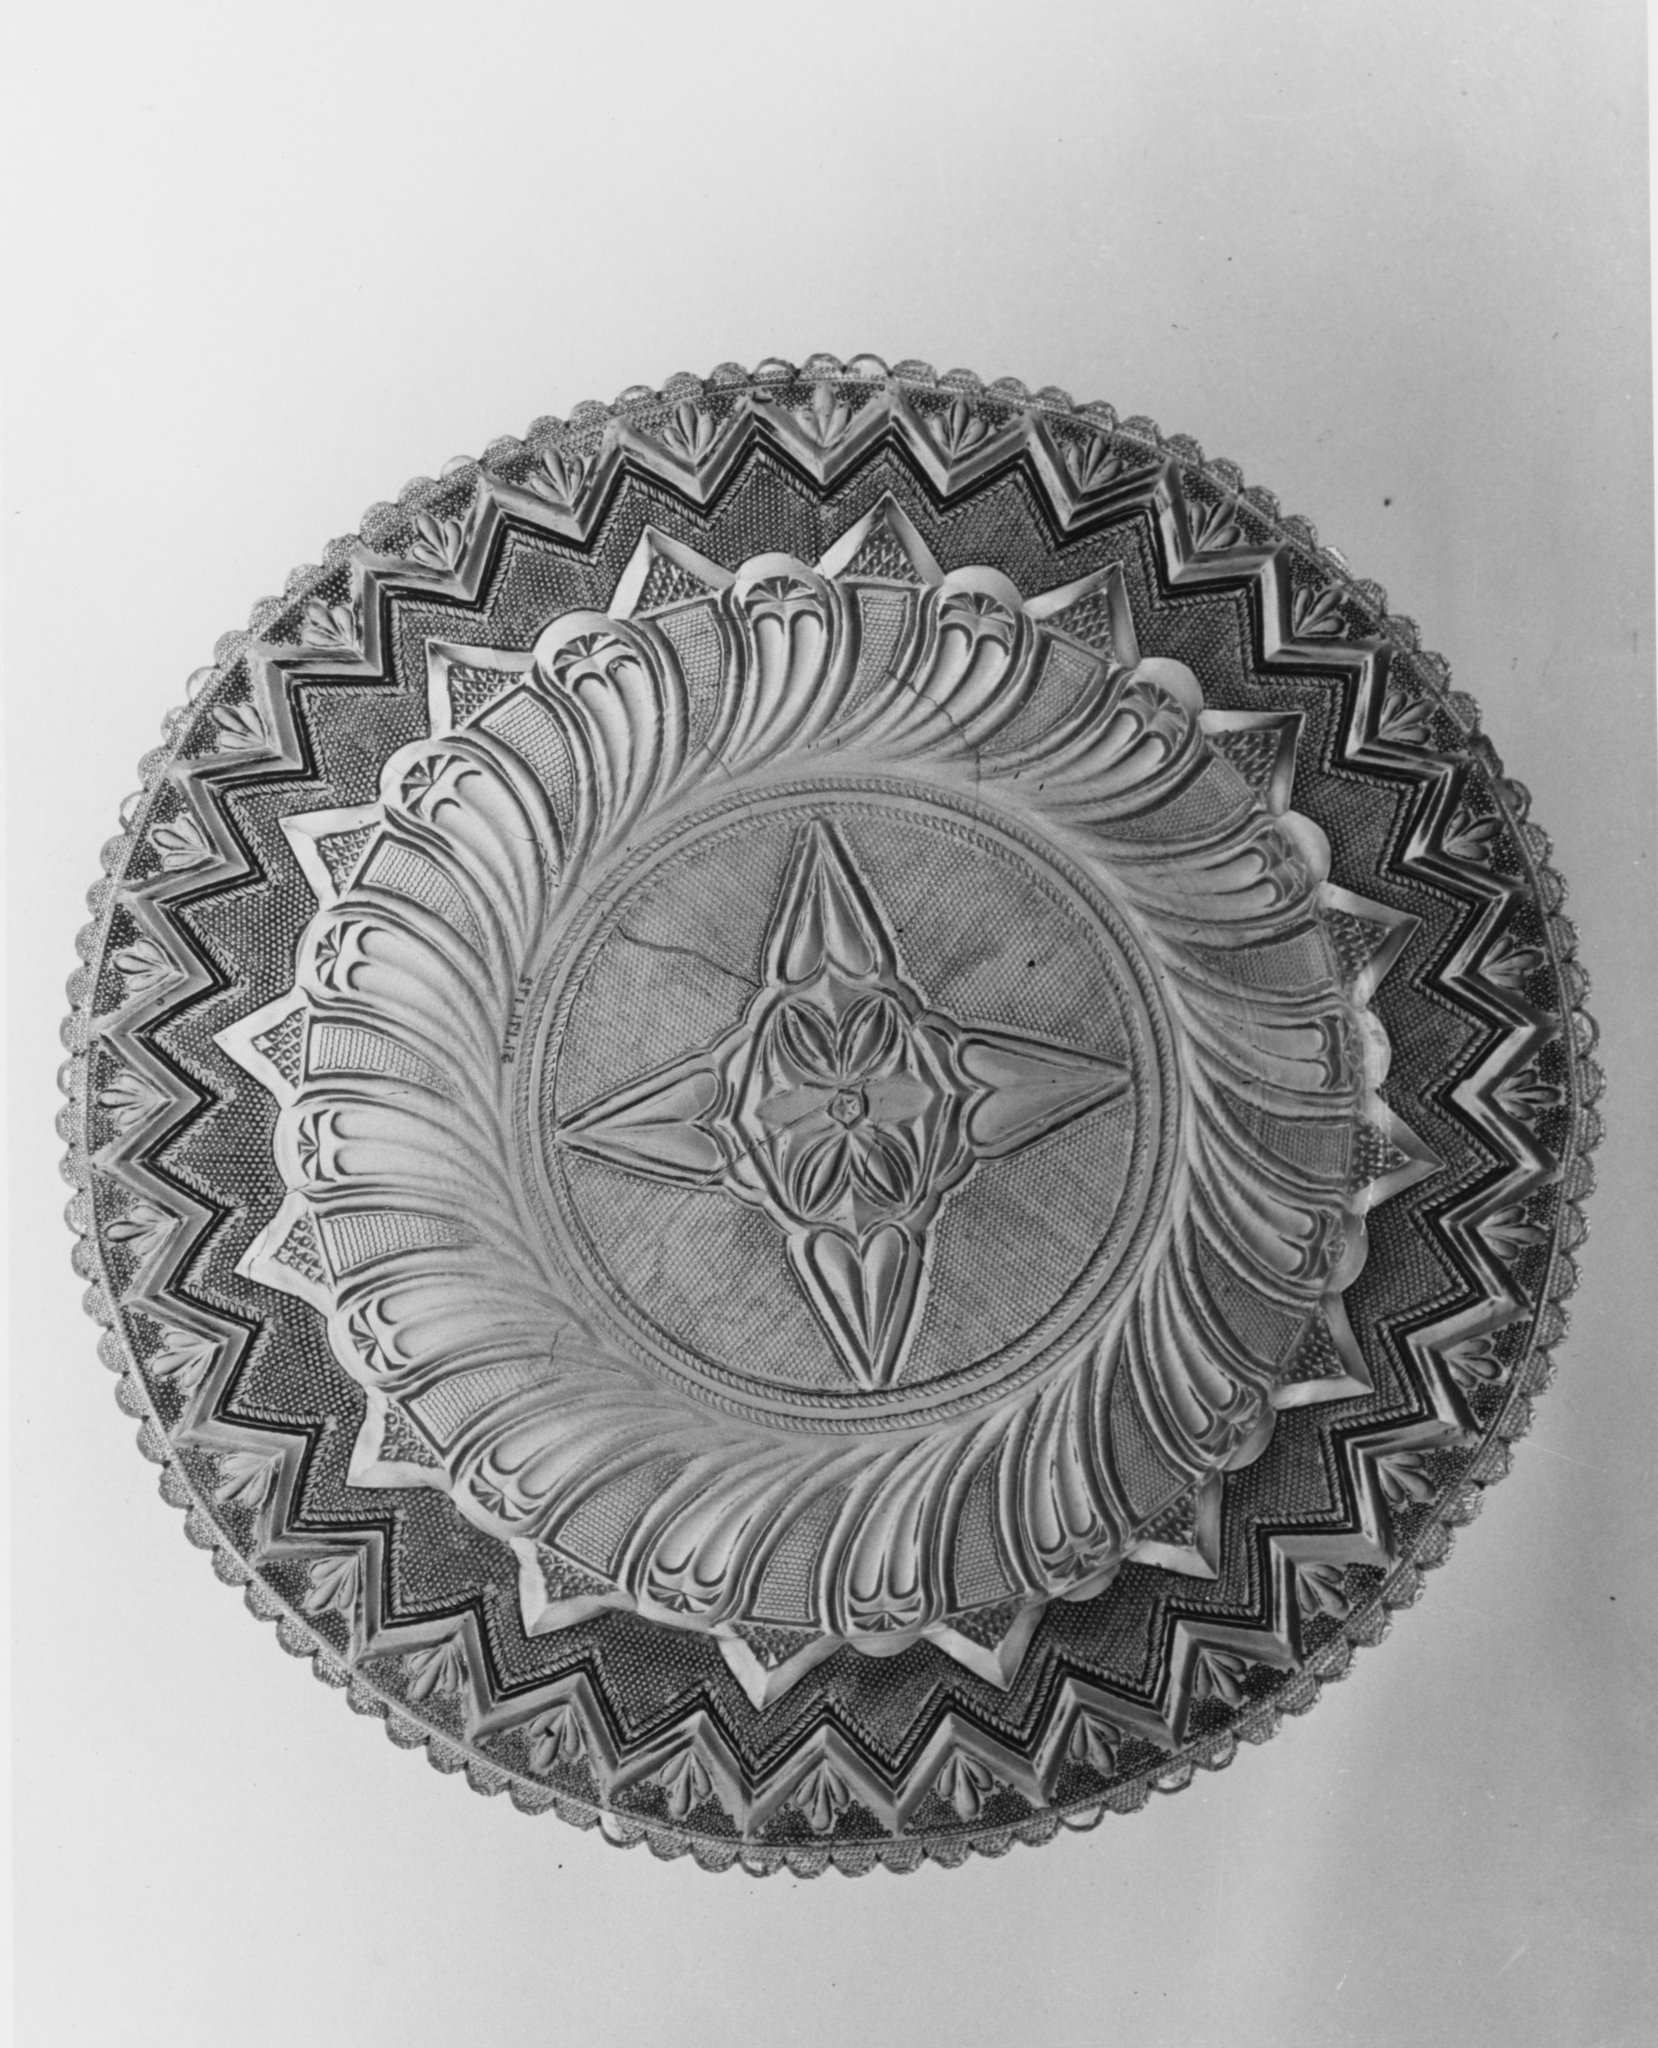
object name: dish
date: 1830-1840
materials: glass